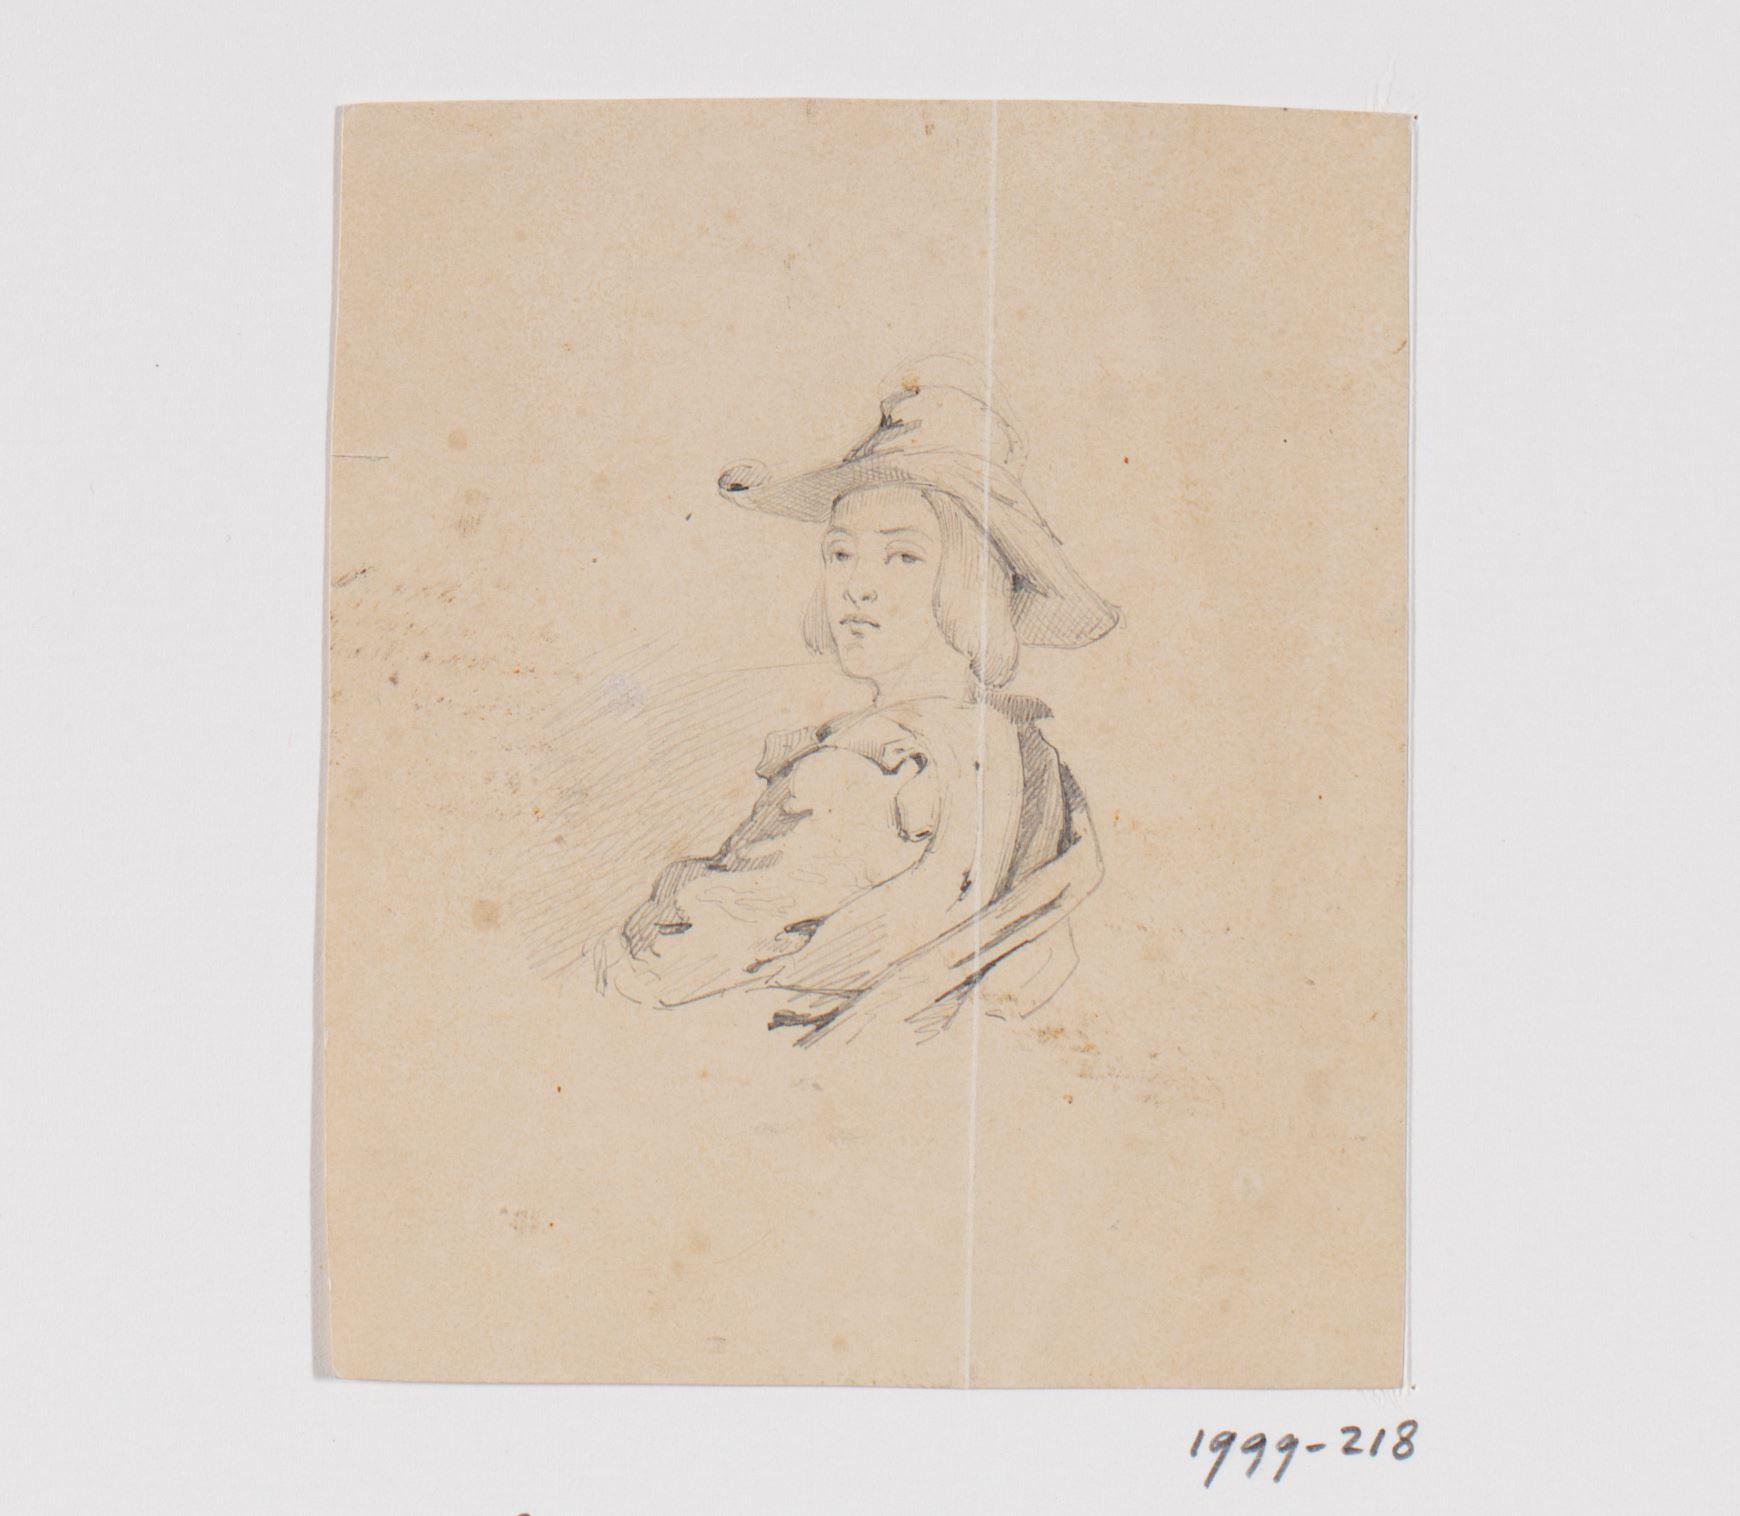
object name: drawing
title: Portret van een onbekend Europees meisje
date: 1860-1872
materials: paper, pencil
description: mogelijk kopie naar prent. artikel over deze collectie in Bulletin van het Rijksmuseum 49 [2001], nr. 4, pp.343 e.v.